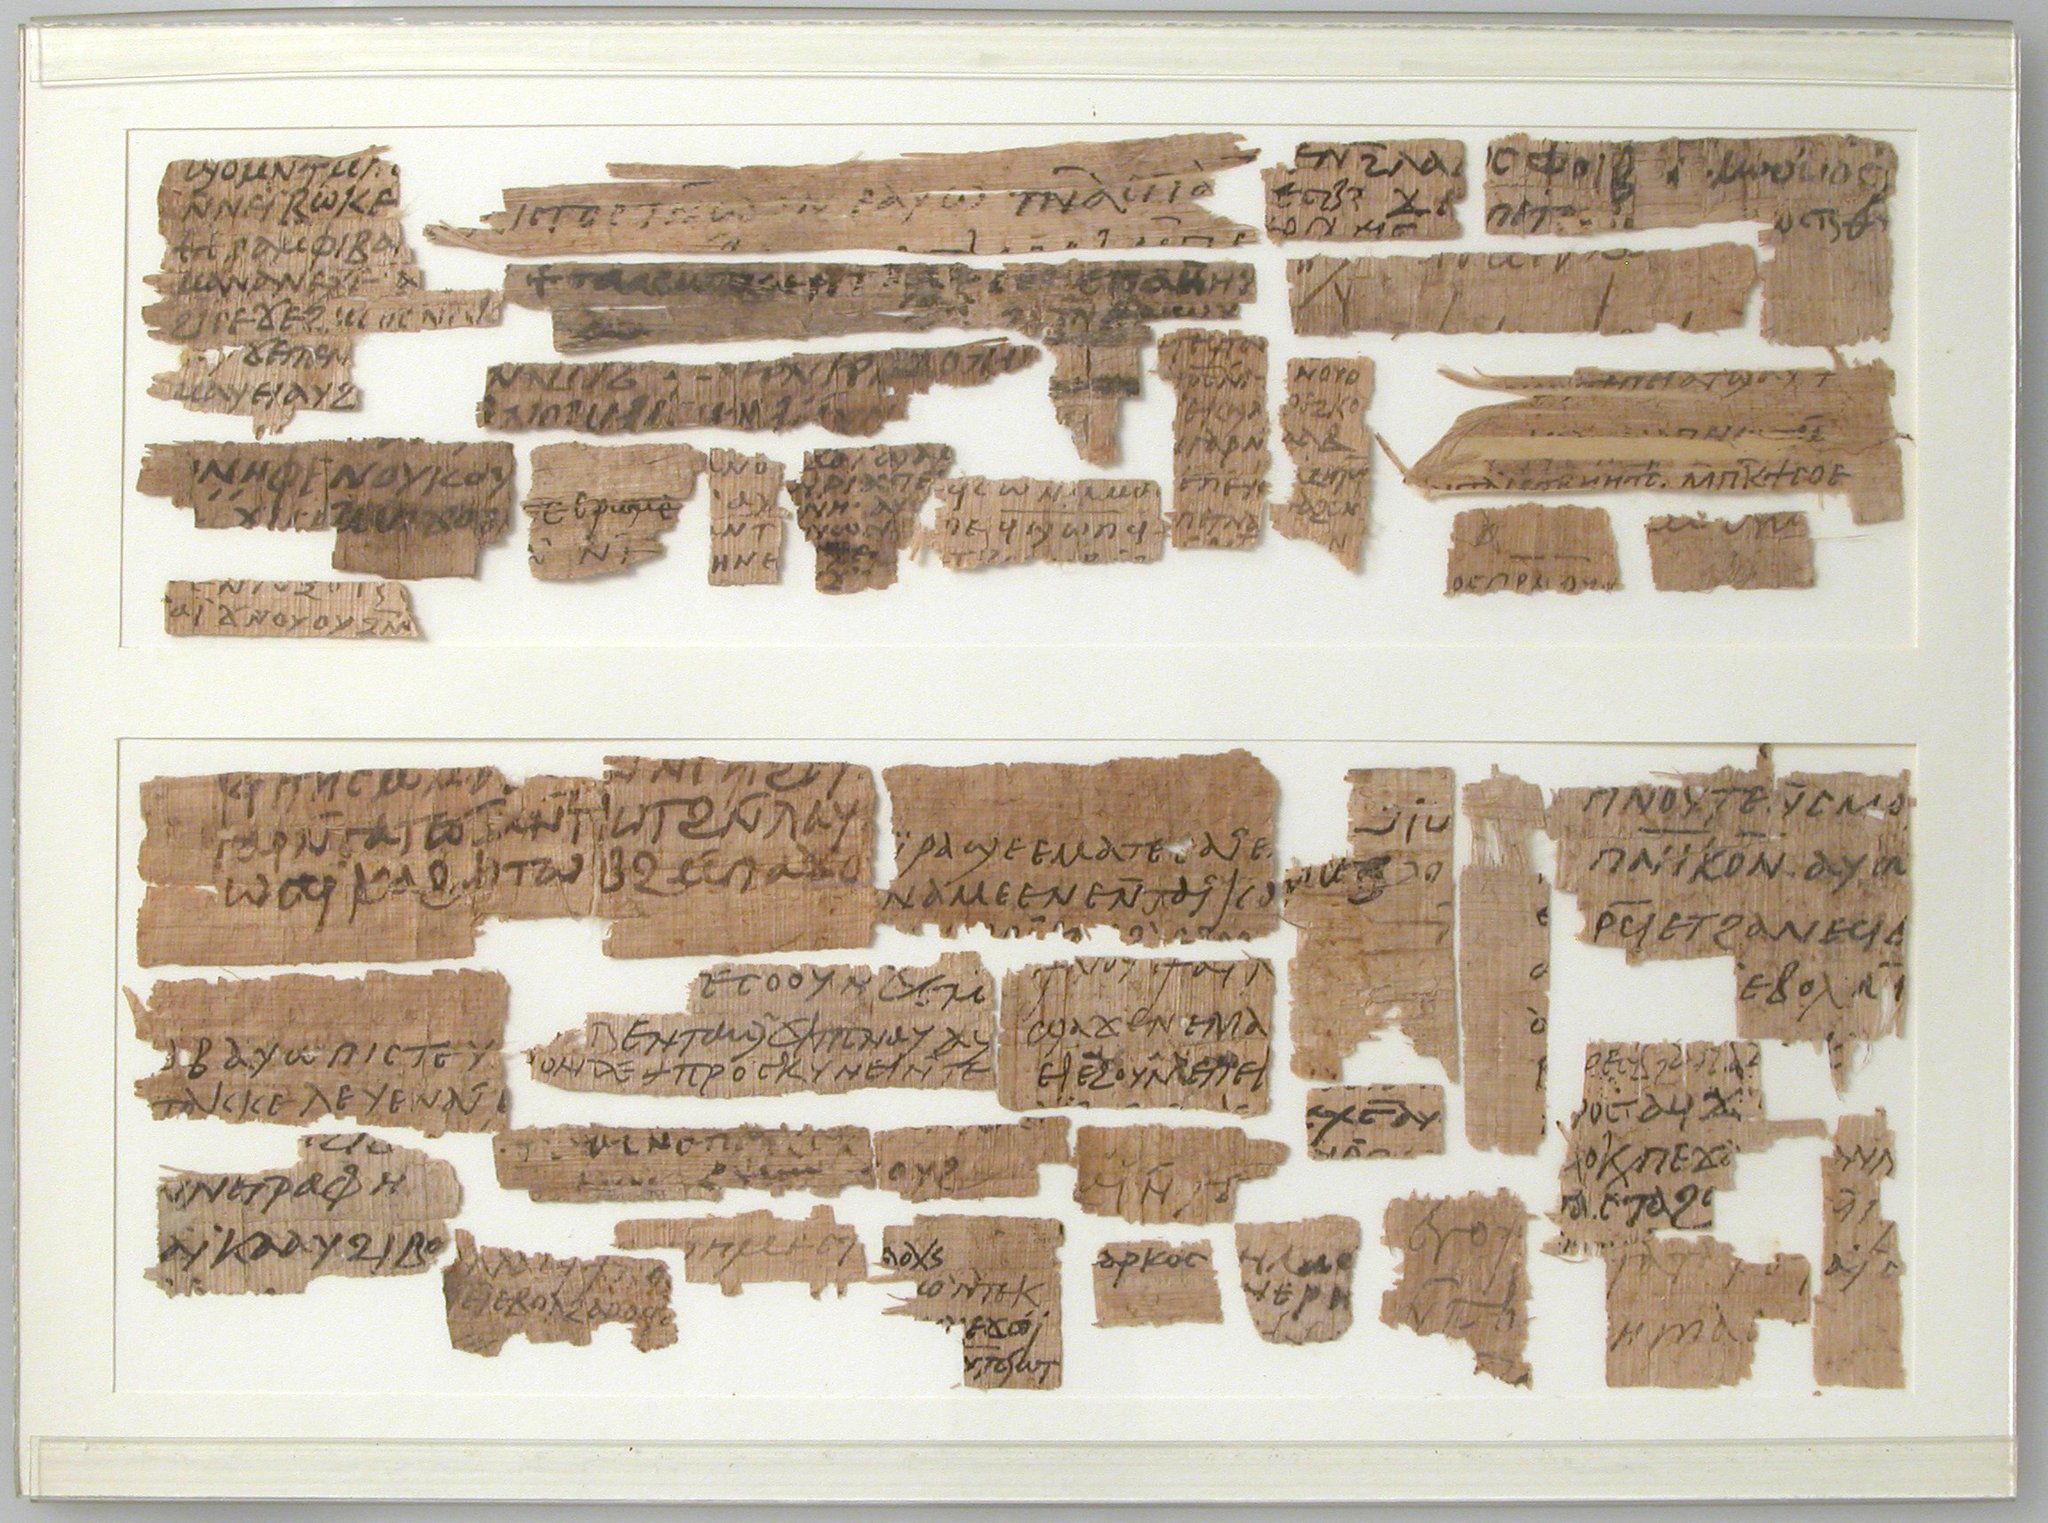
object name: fragment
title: Papyri Fragments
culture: coptic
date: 601-700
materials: ink, papyrus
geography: egypt